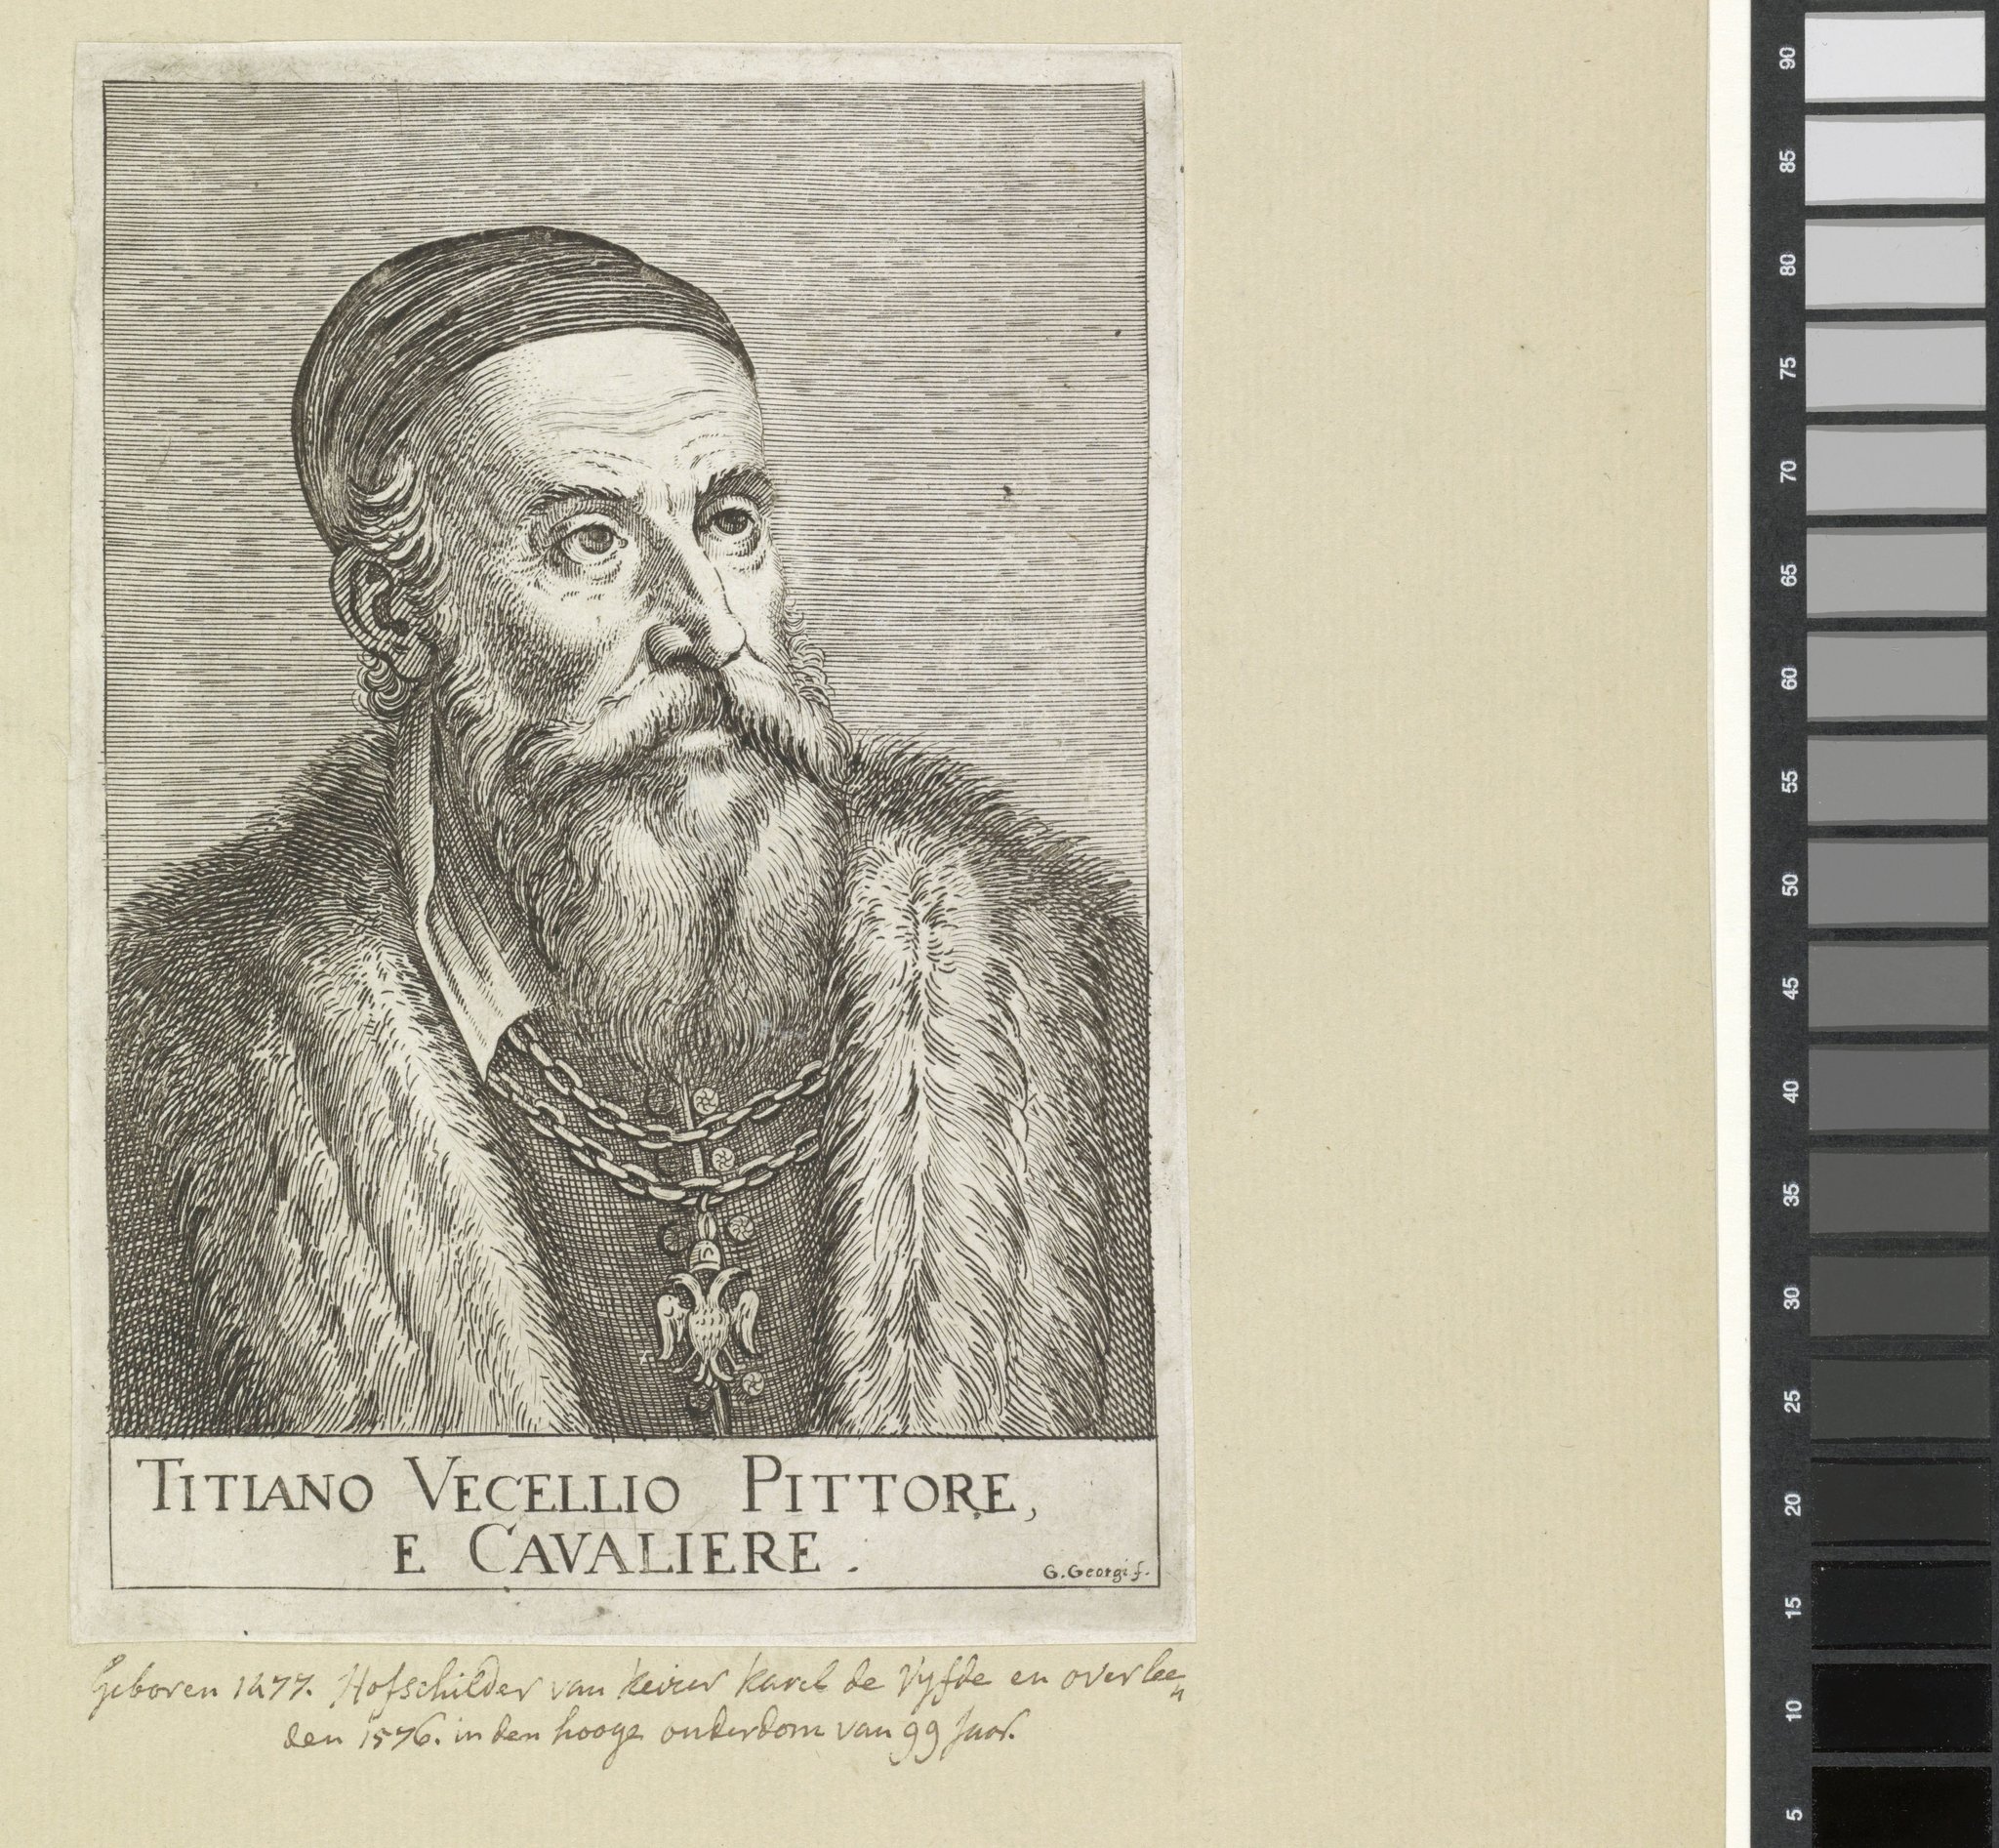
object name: print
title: Portret van schilder Titiaan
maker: giovanni georgi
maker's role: print maker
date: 1600-1699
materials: paper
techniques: etching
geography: italy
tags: venice, draughtsman, titiaan, historical persons, portrait, self-portrait of artist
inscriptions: collector's mark: Lugt 2228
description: Naar geschilderd zelfportret van Titiaan in de Staatliche Museen Preussischer Kulturbesitz, Gemäldegalerie te Berlijn.